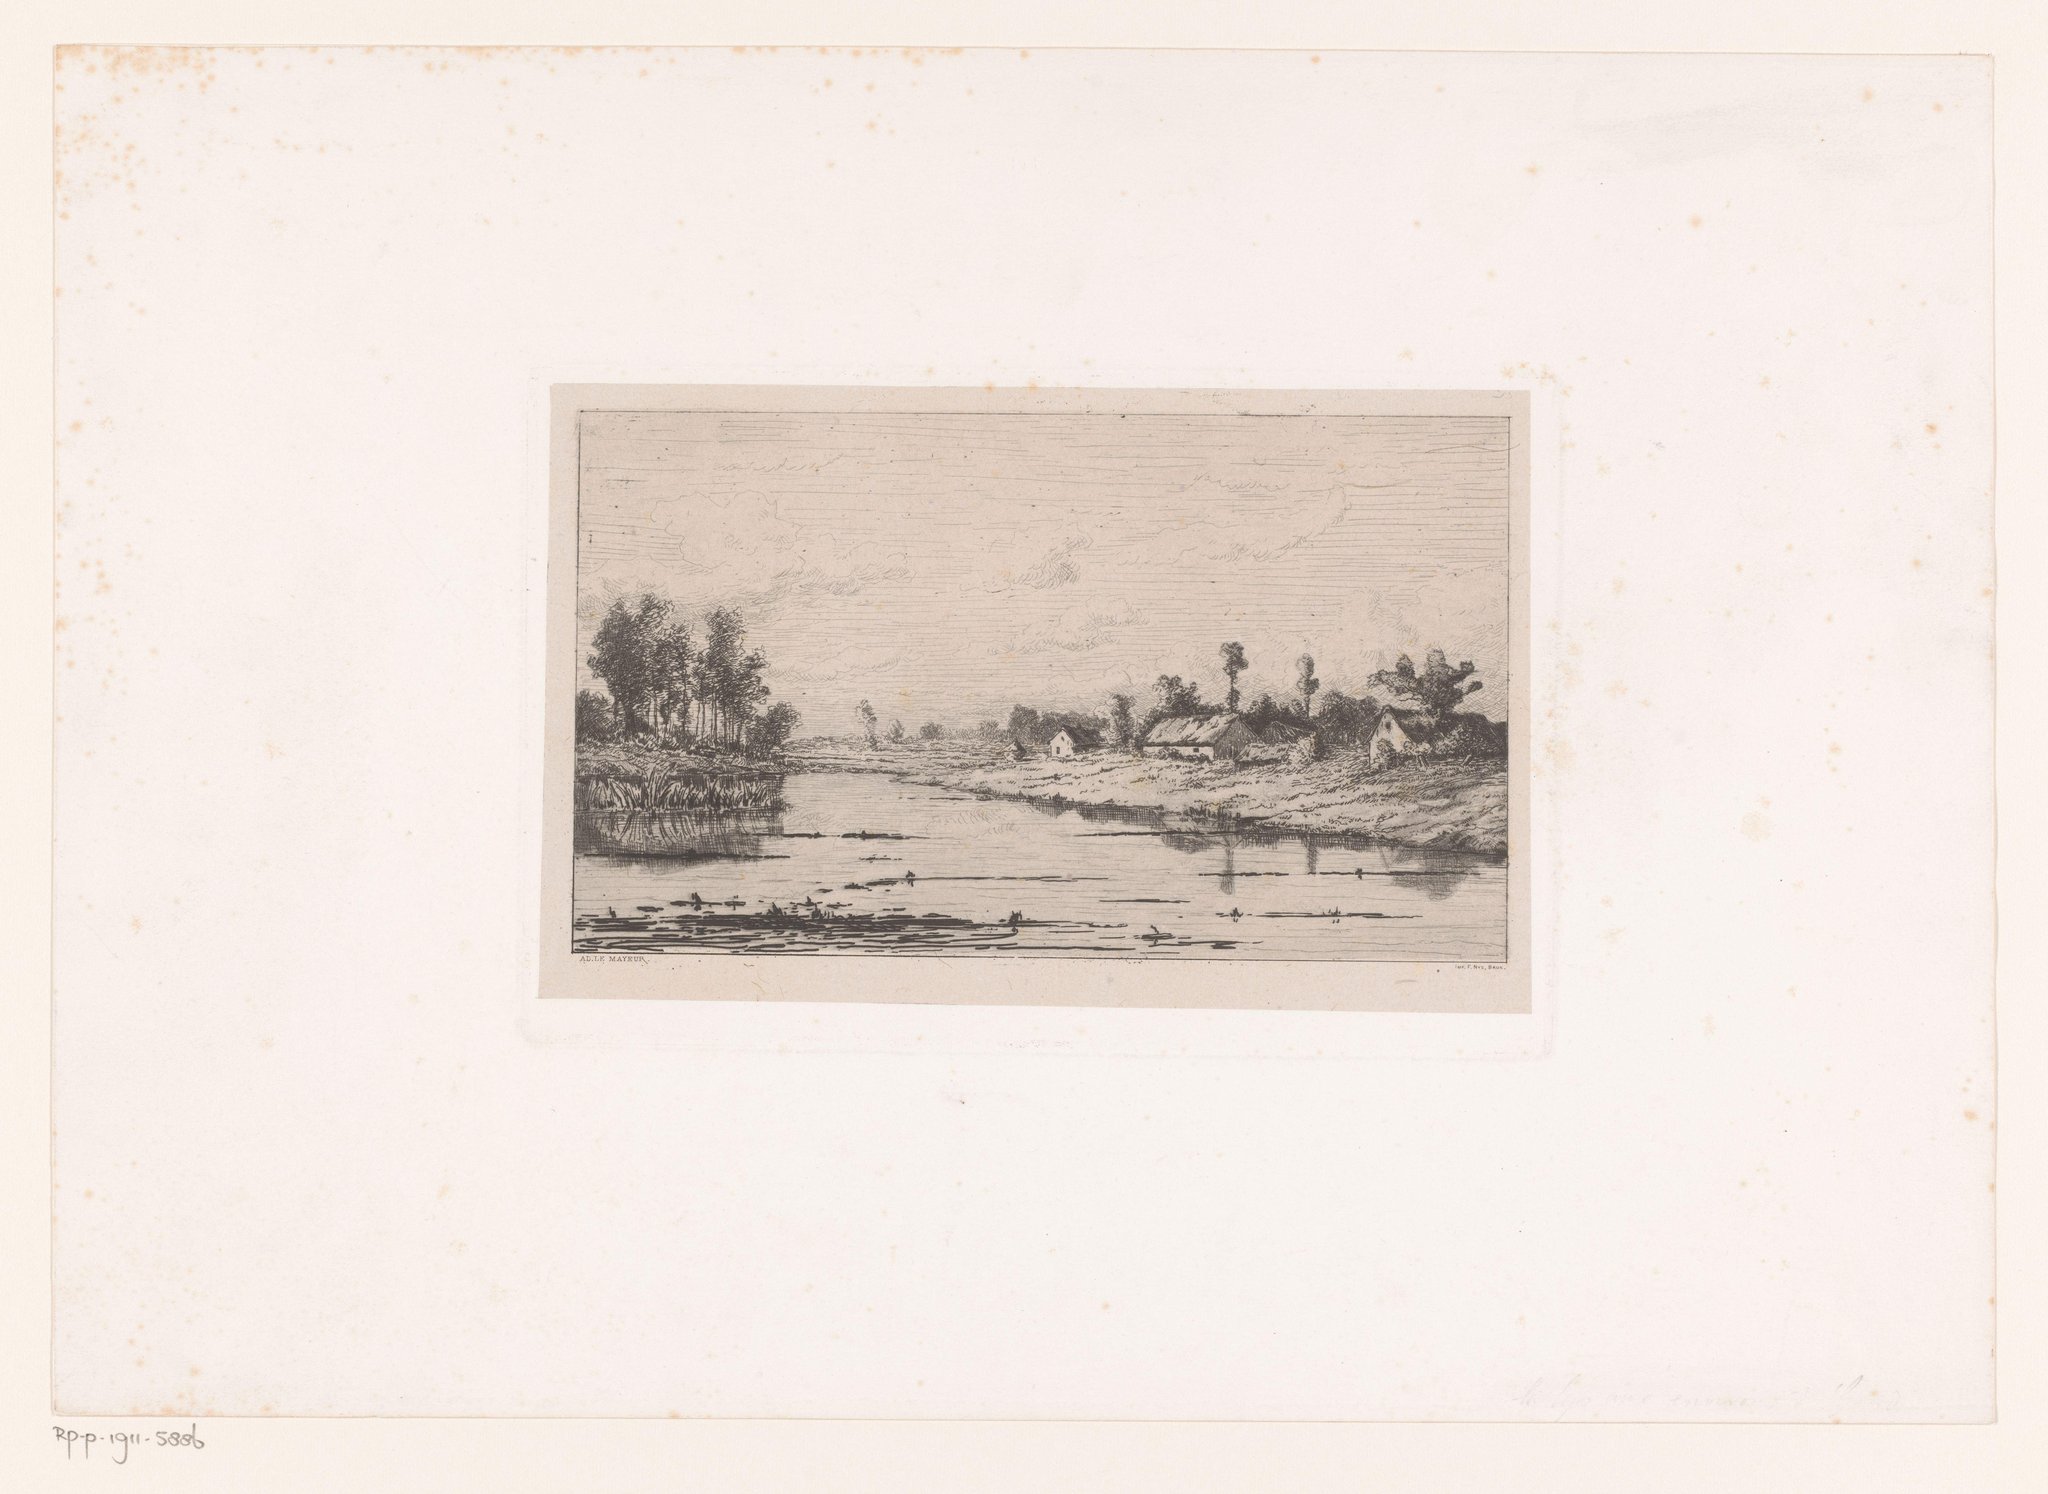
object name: print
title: Rivierlandschap met enkele gebouwen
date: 1854-1911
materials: paper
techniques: etching, intaglio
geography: brussels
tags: river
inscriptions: collector's mark: Lugt 2228